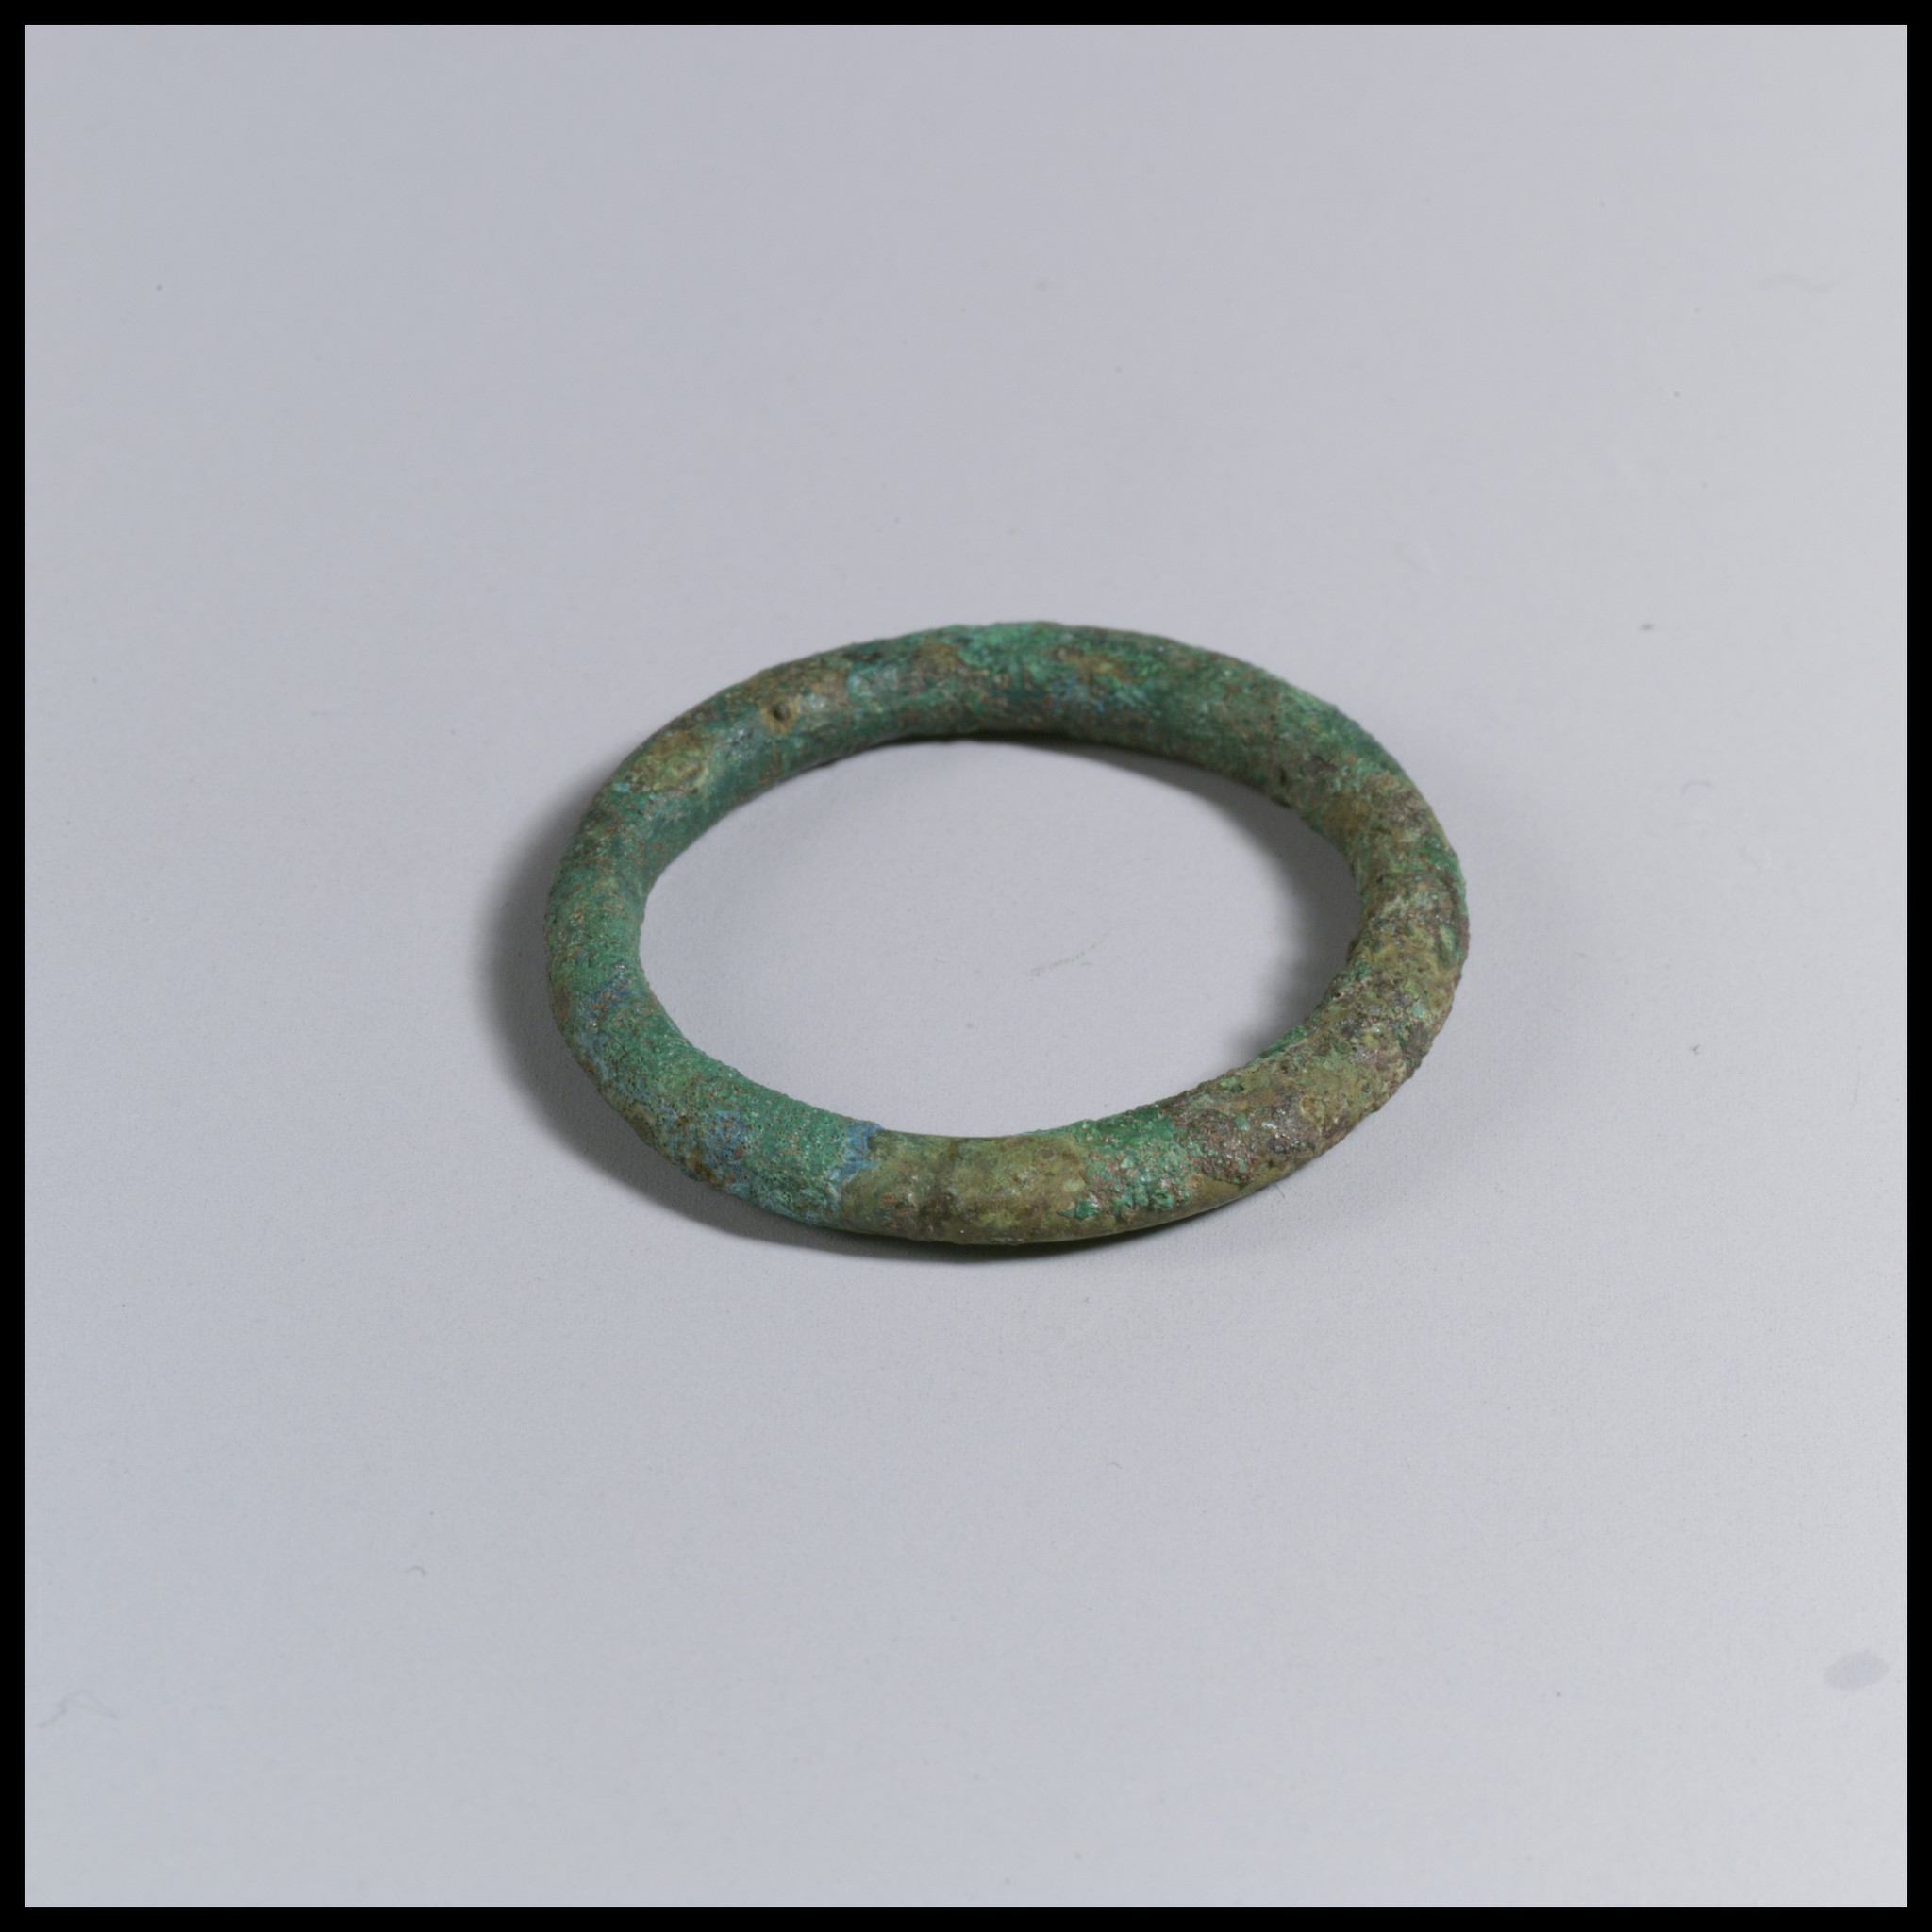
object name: ring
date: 7000 BCE-330 CE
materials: bronze